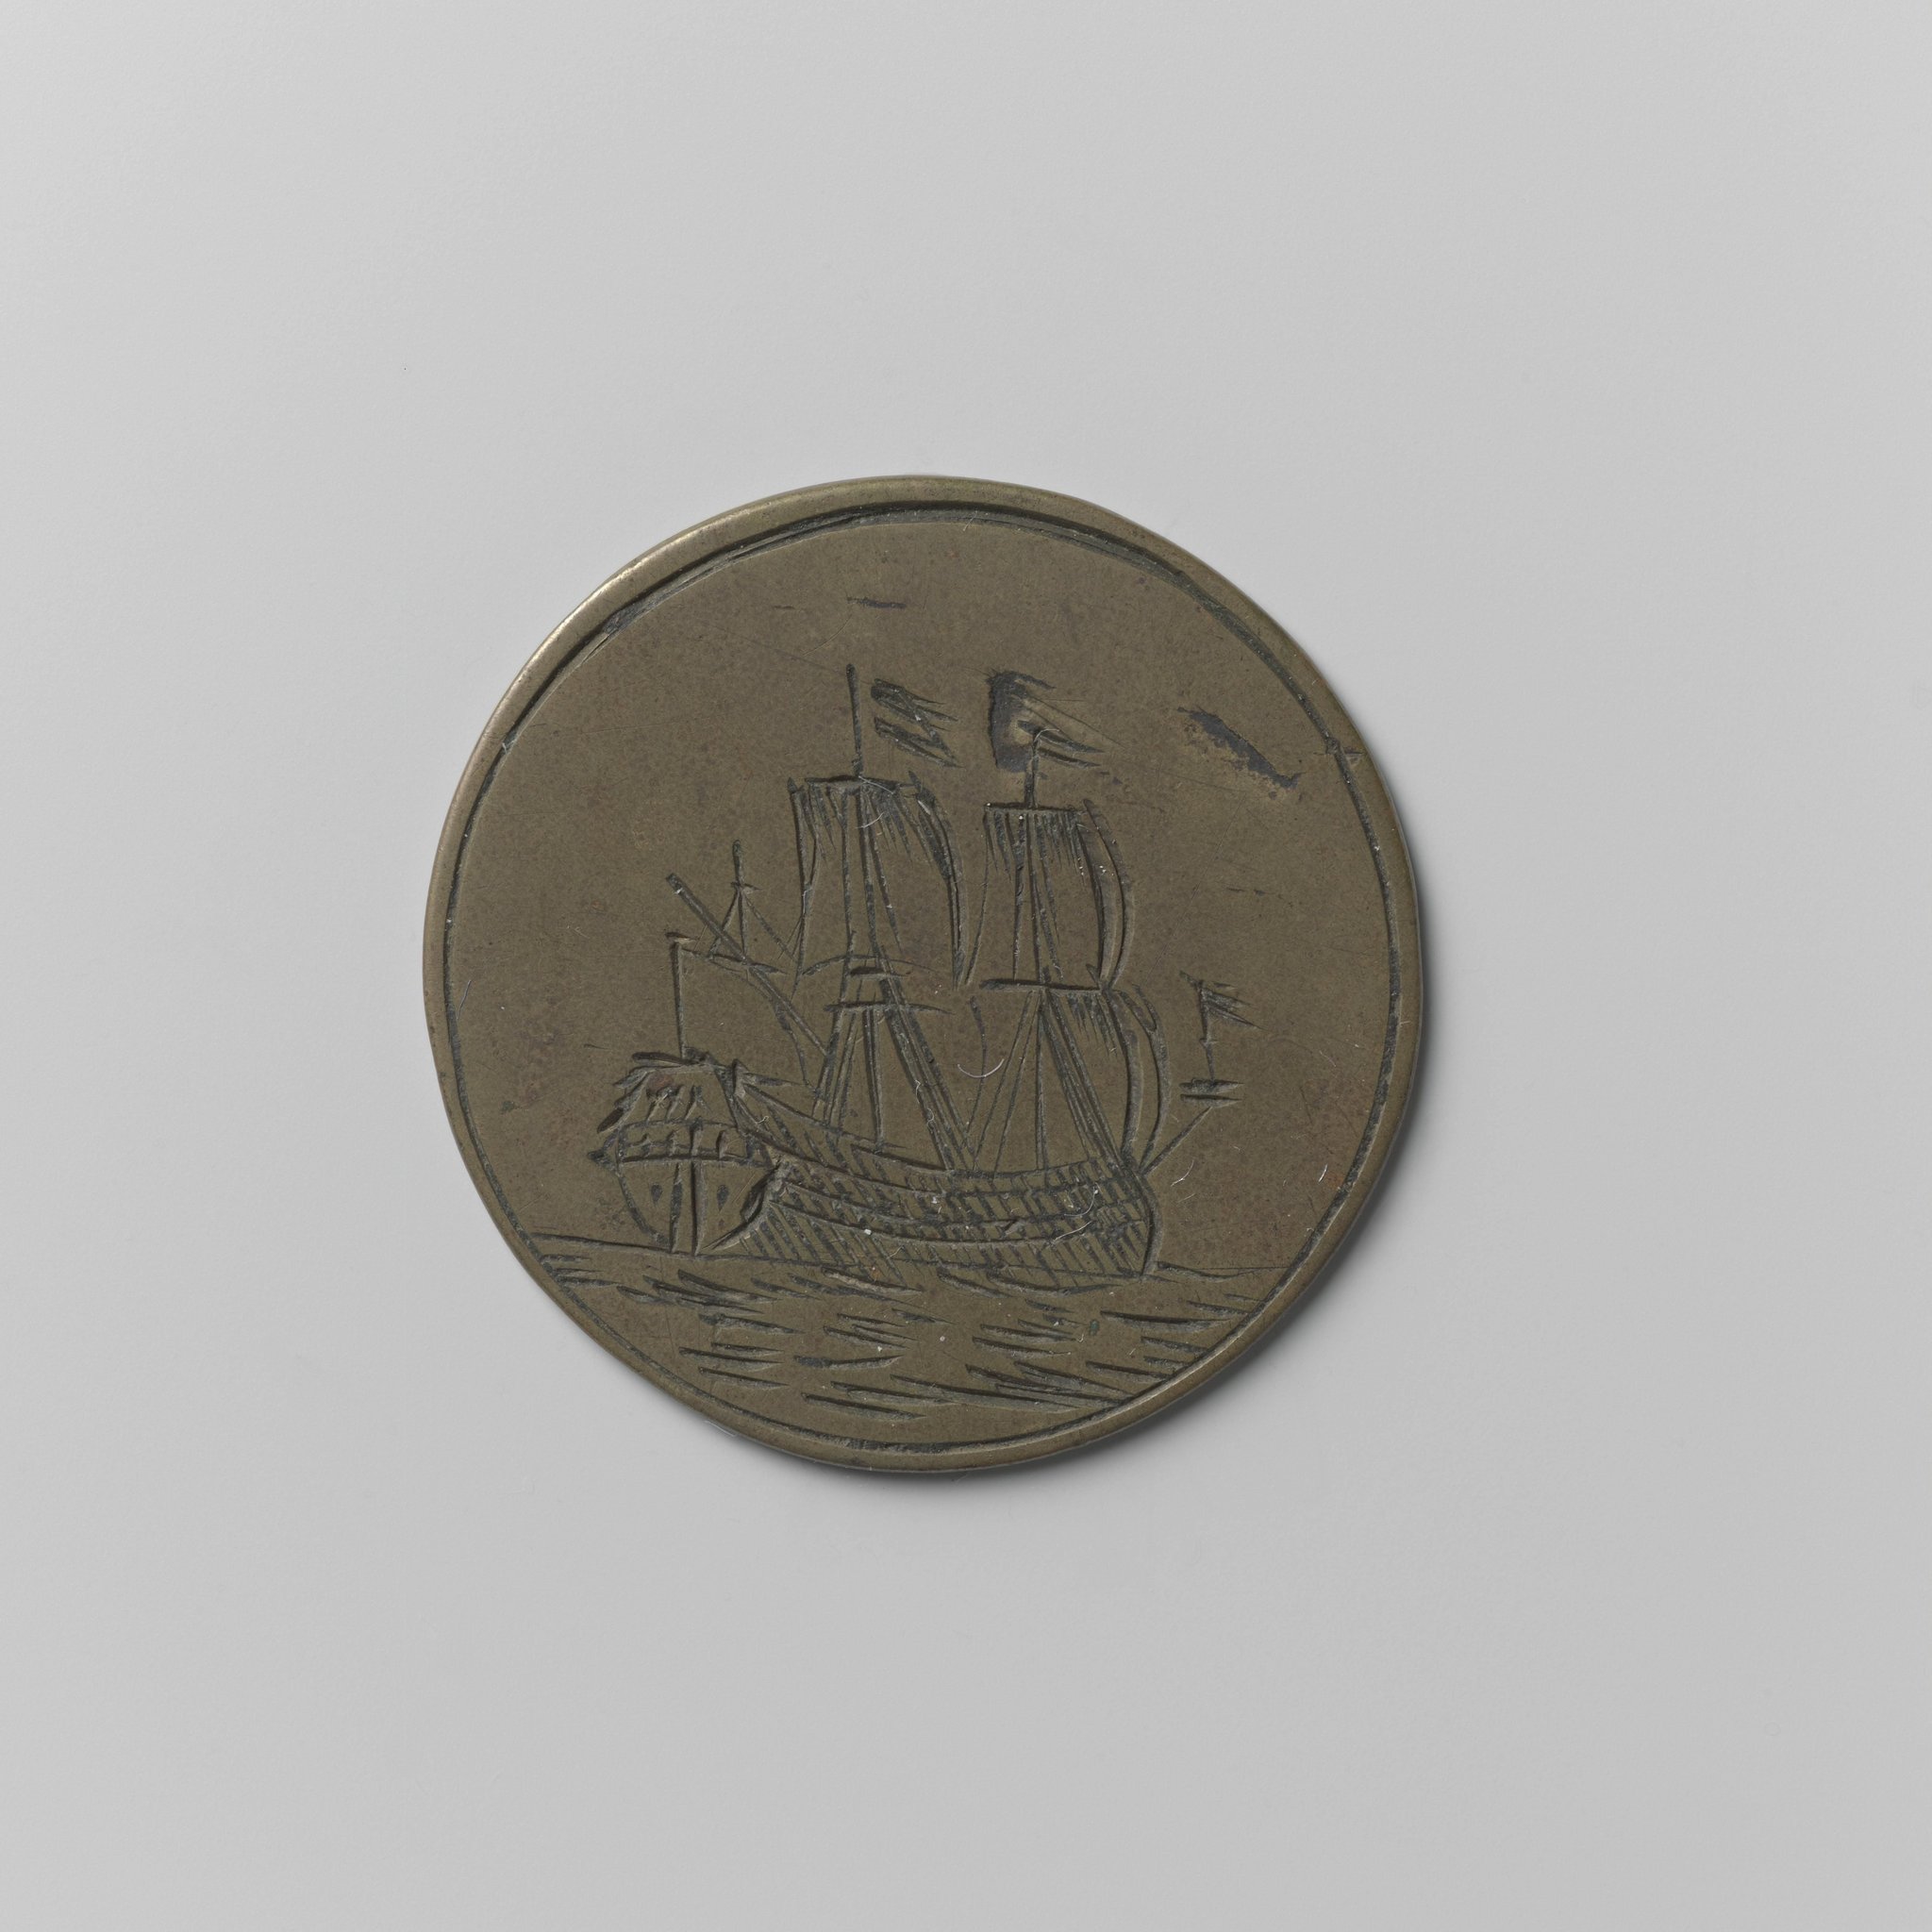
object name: medal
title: Schippersgilde, gildepenning van Wormer Jansen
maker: Anonymous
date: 1703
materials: copper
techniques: engraving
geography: netherlands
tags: wormer jansen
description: Koperen penning. Voorzijde: naar rechts varende driemaster met twee getuigde en een afgetuigde mast; k.z:opschrift